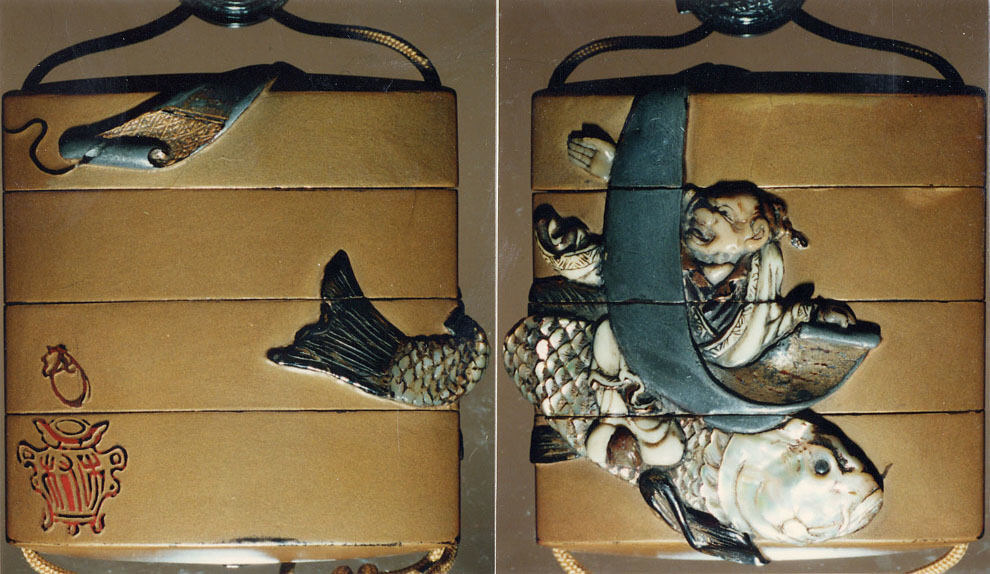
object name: inrō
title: Case (Inrō) with Design of Kinkō Riding a Carp and Holding a Long Scroll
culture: japanese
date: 1801-1900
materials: gold, ivory, lacquer, metal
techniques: fundame, hiramakie, inlay, roiro, stain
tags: scrolls,men,fish